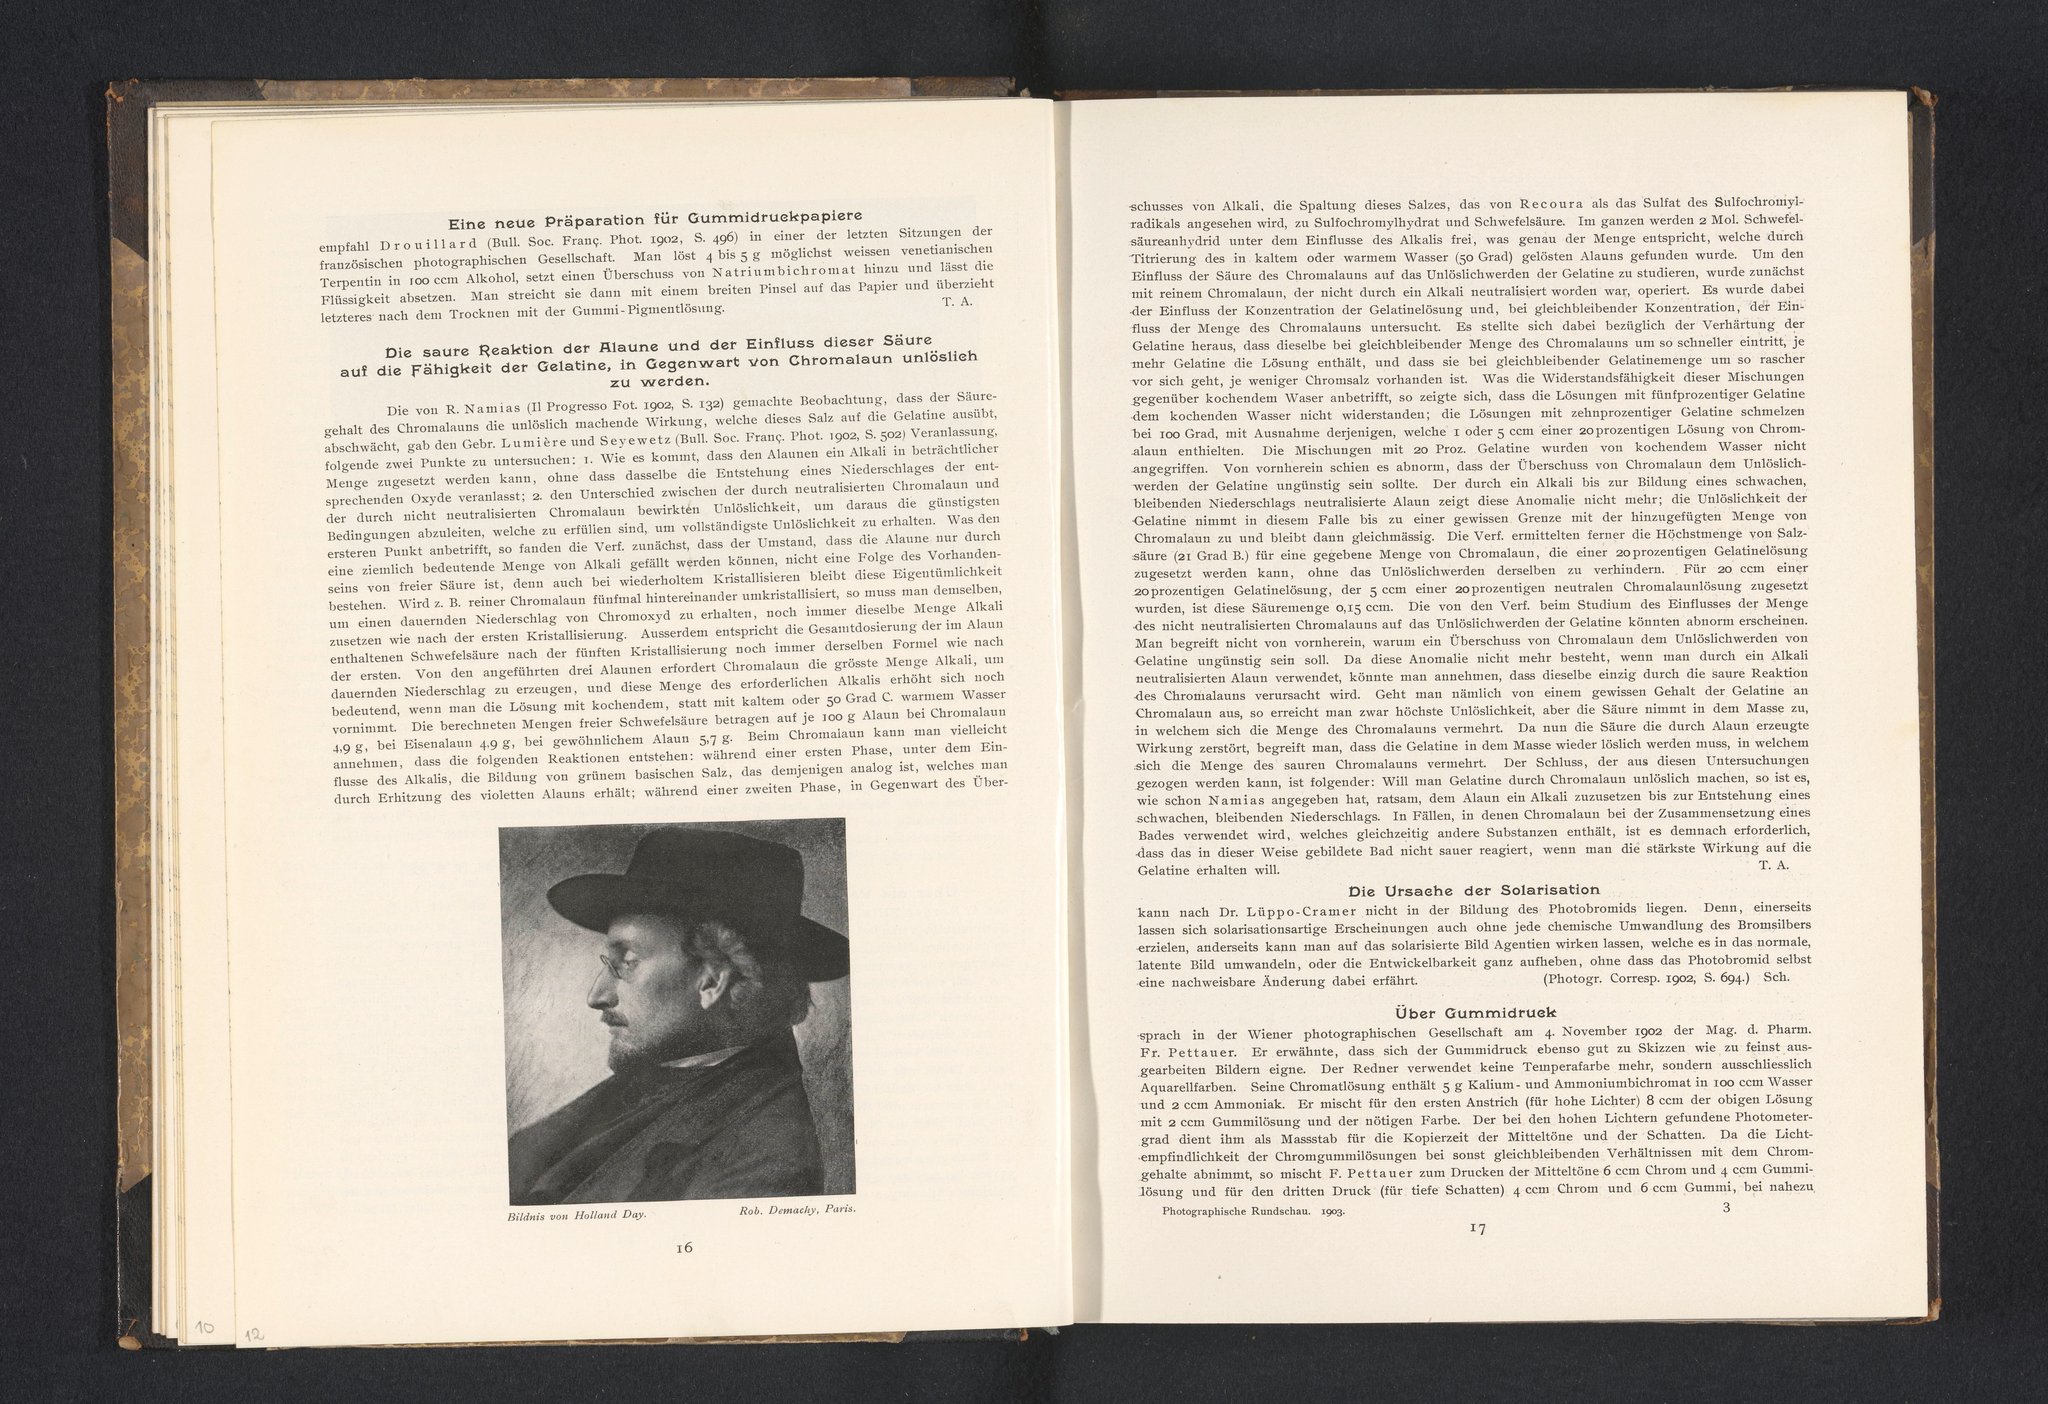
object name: photomechanical print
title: Bildnis von Holland Day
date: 1898-1903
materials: paper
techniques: autotype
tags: printer, historical persons